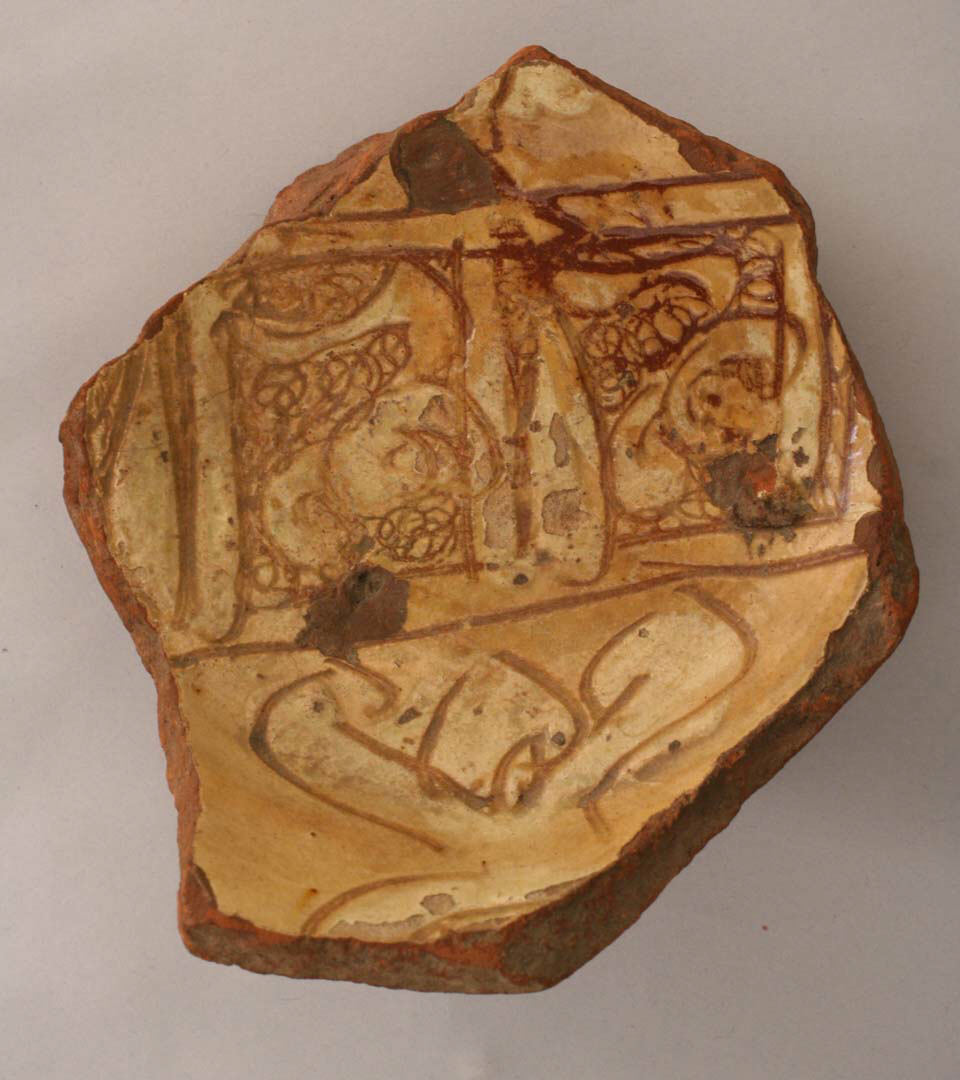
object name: fragment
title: Fragment of a Bowl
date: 1301-1500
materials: earthenware, glaze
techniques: coloring, incising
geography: egypt